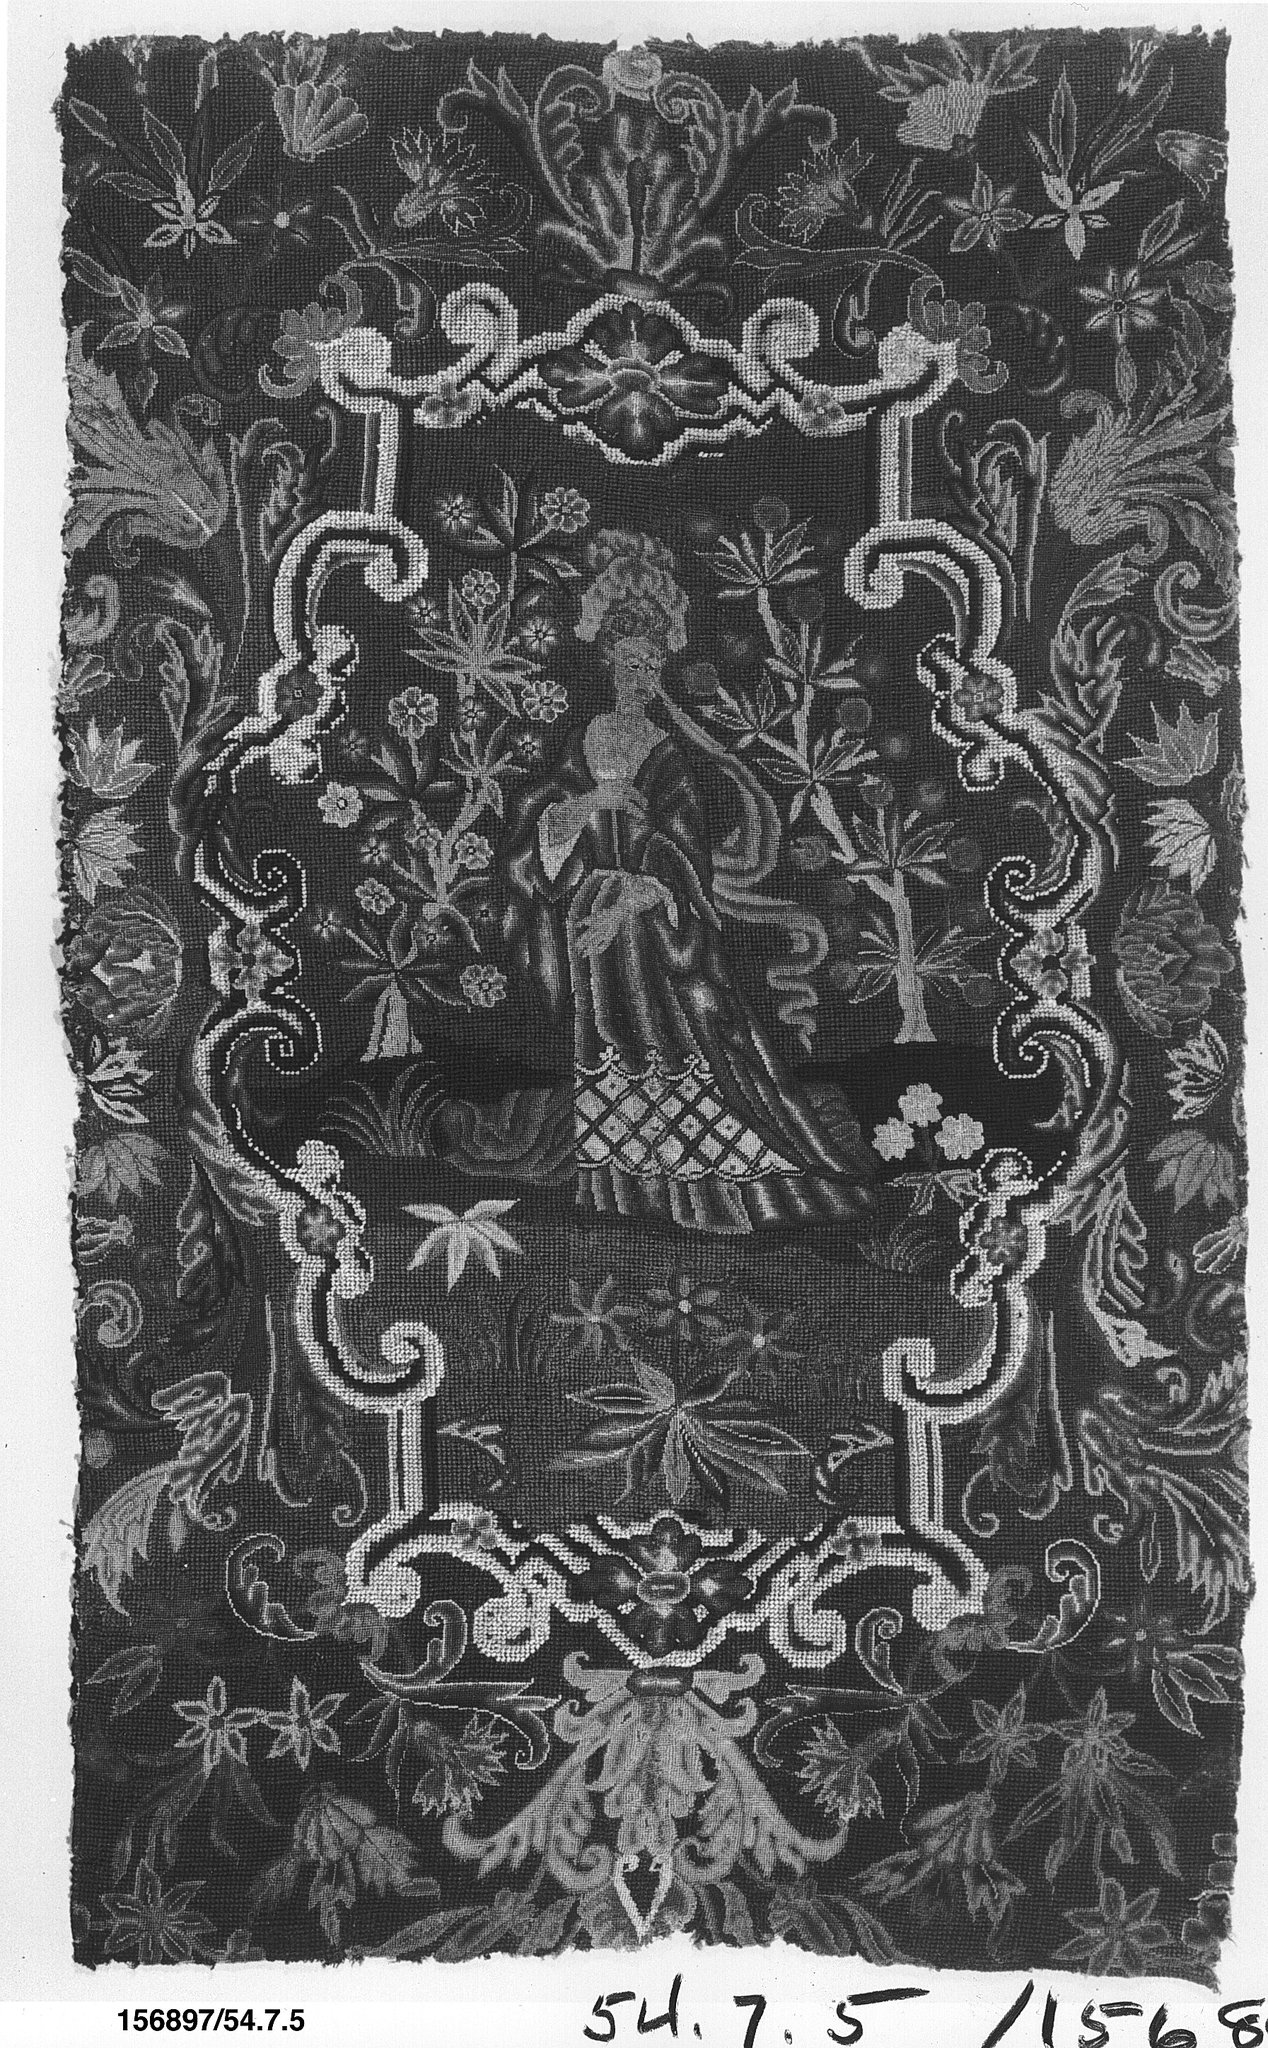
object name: panel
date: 1701-1733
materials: canvas, silk, wool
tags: women,flowers